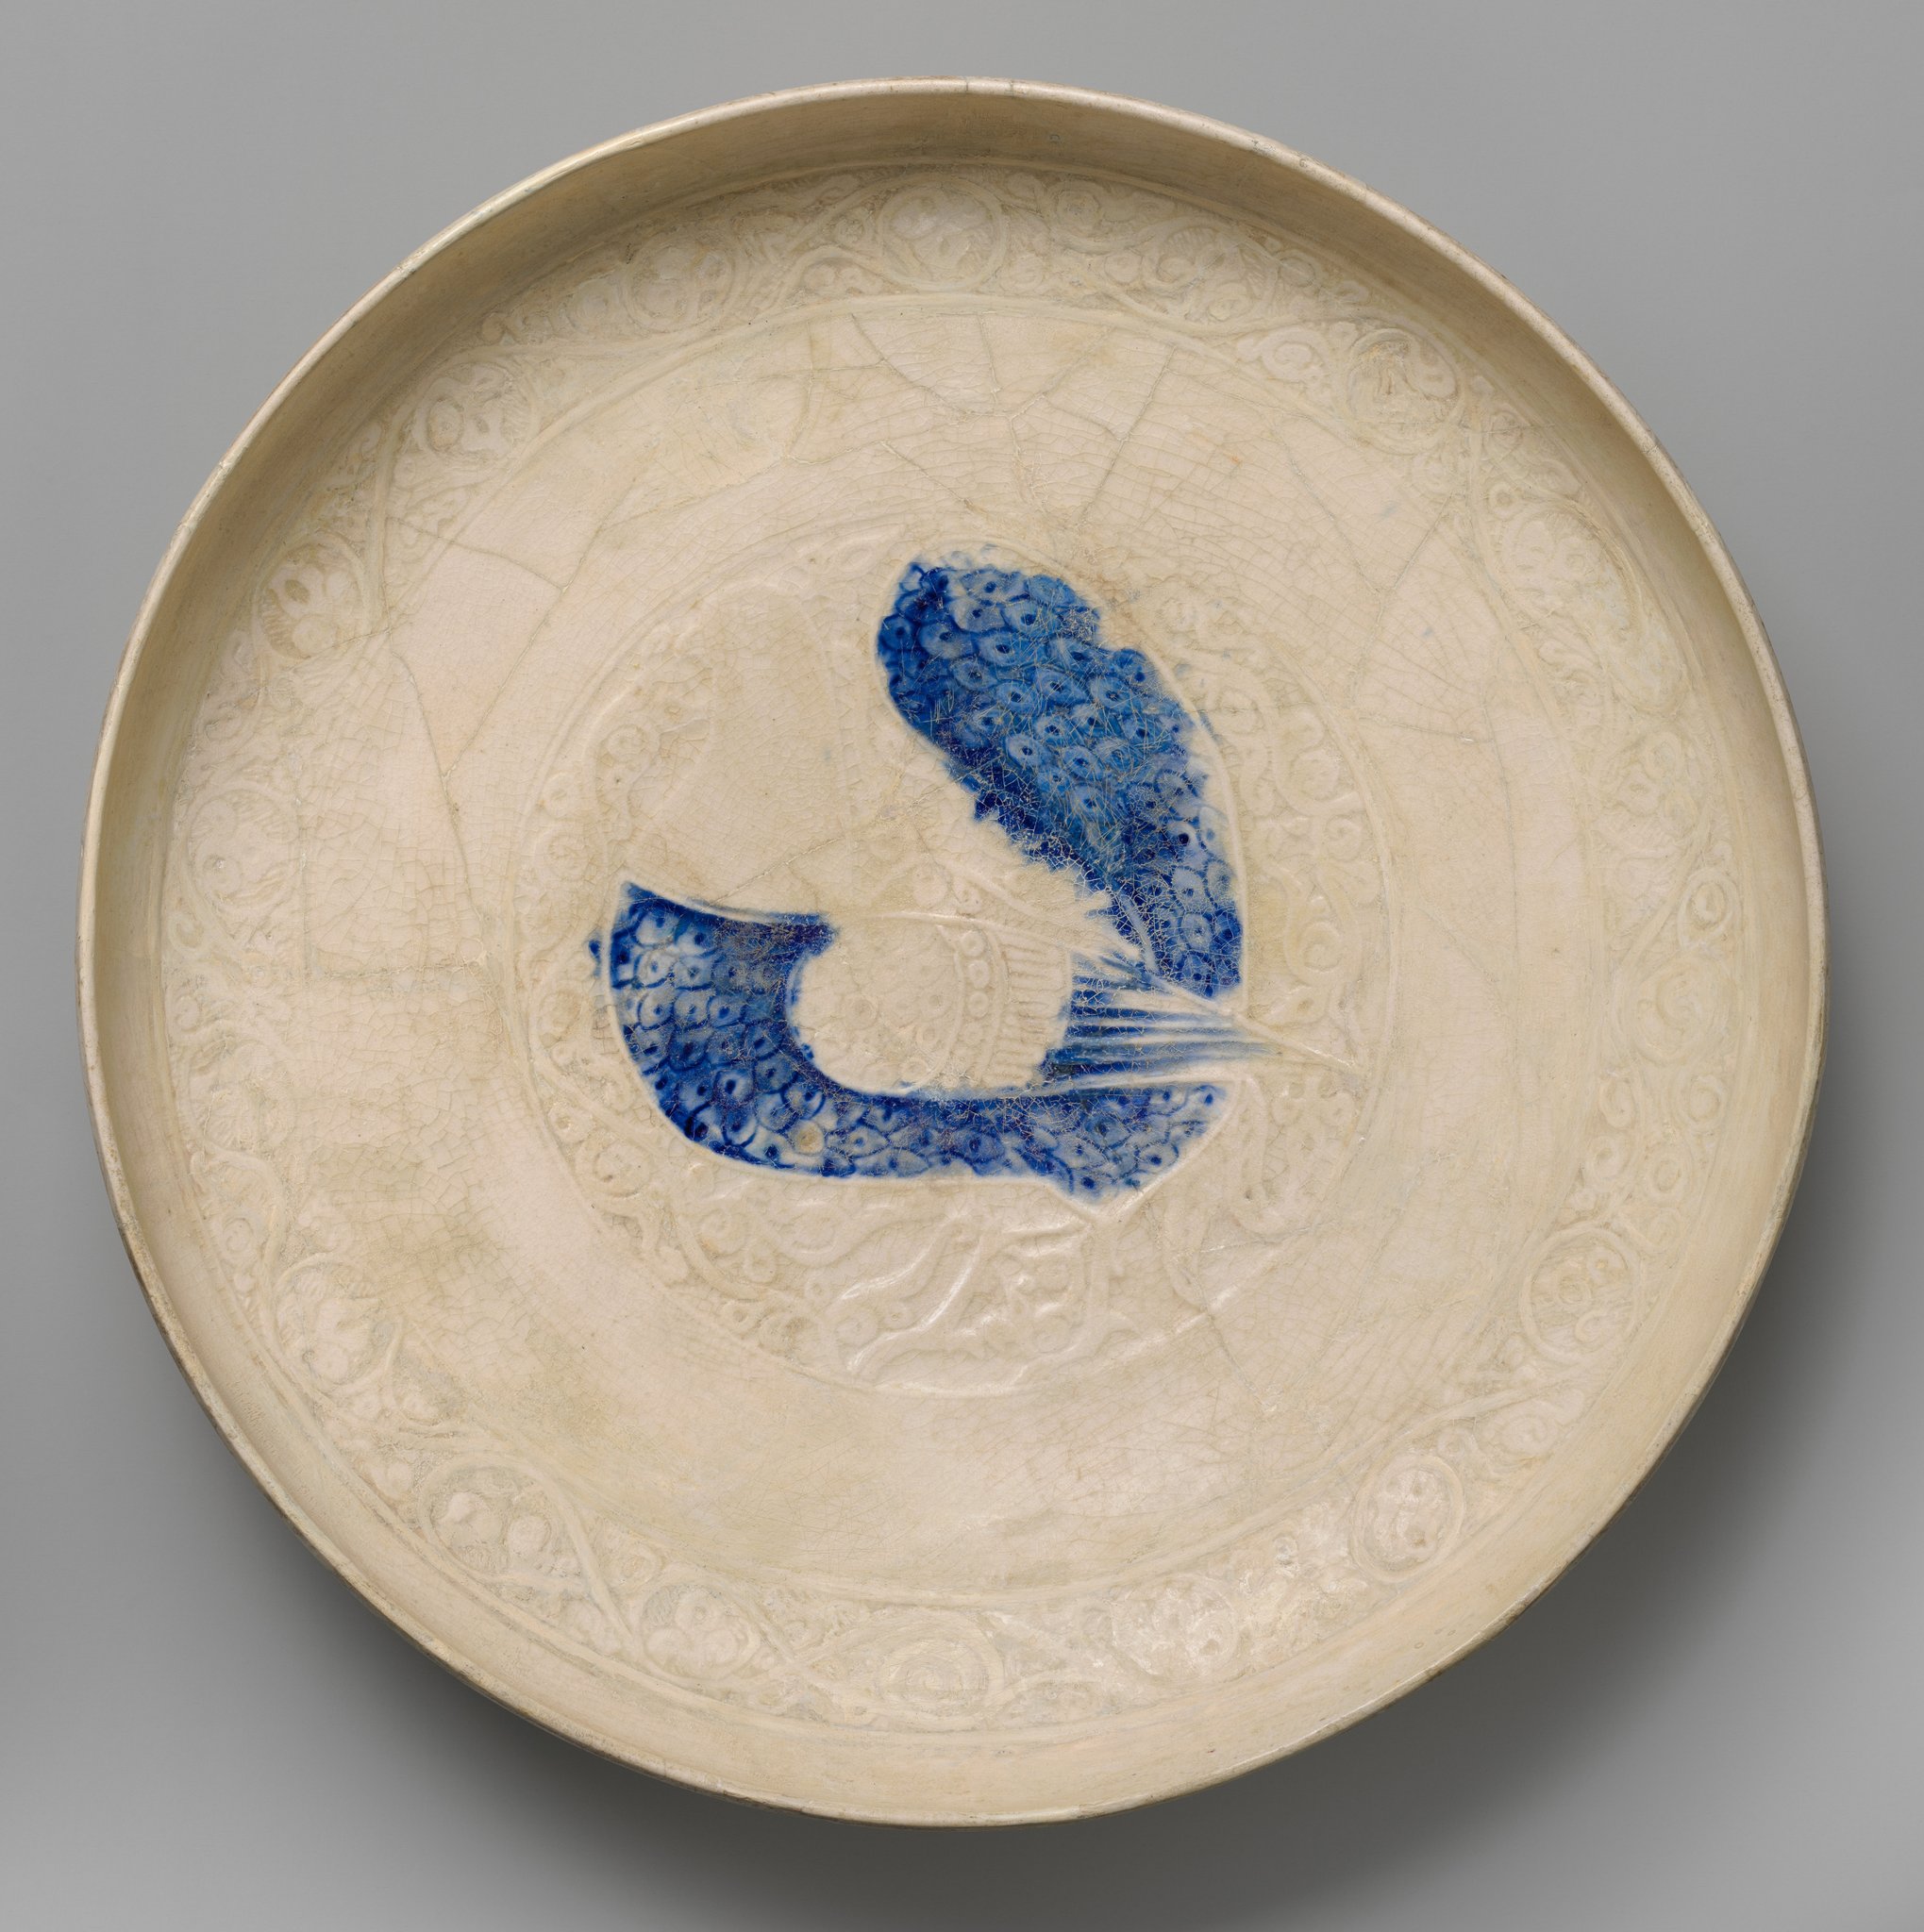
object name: bowl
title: White Bowl with a Blue Peacock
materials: glaze, stonepaste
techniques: incising, painting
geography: iran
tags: peacocks